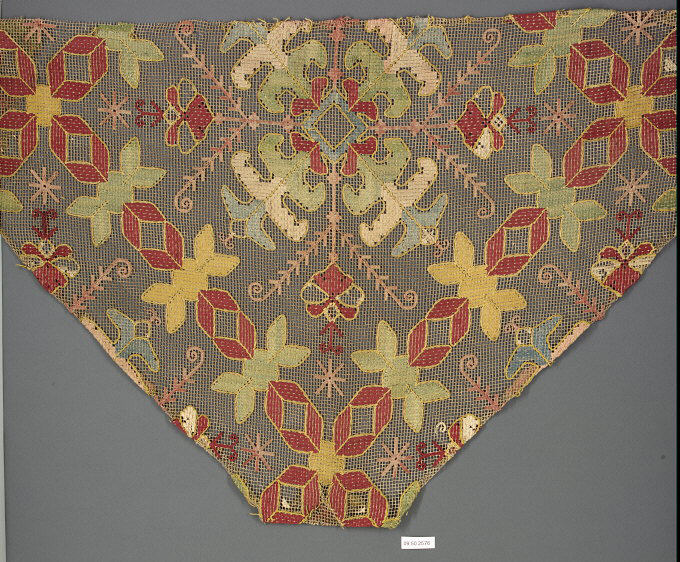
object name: fragment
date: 1701-1900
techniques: embroidery